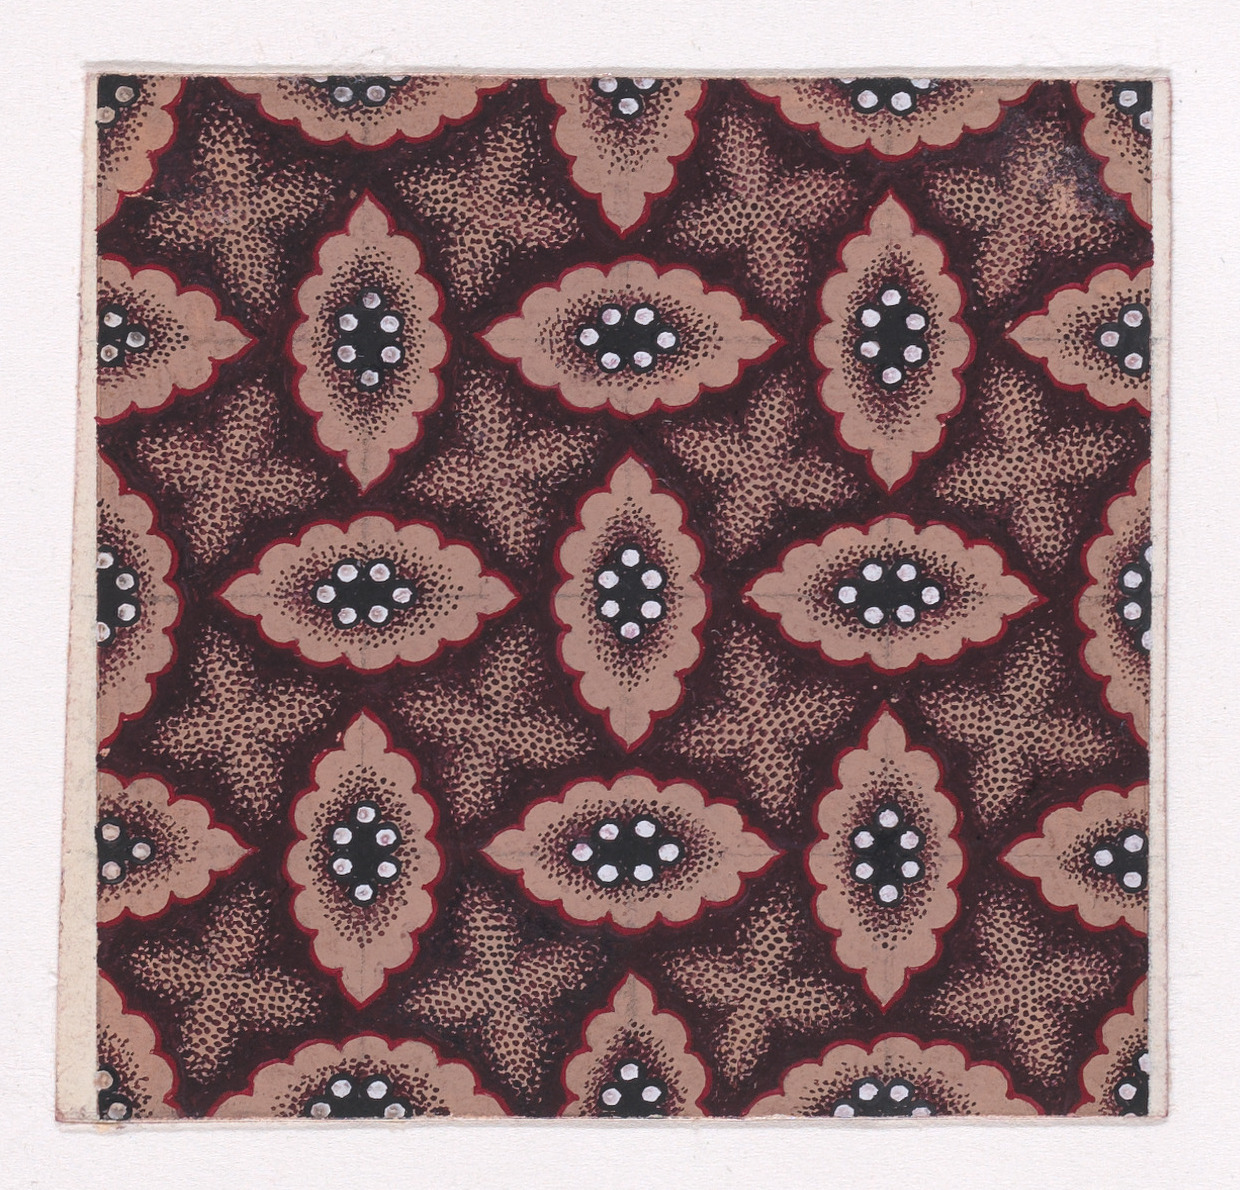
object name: drawing ornament architecture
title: Textile Design with Alternating Strips of Groups of Three Pearls Framed by Undulating Stippled Garlands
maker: anonymous, alsatian, 19th century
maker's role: artist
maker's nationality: alsatian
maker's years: 1800-1900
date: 1840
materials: gouache